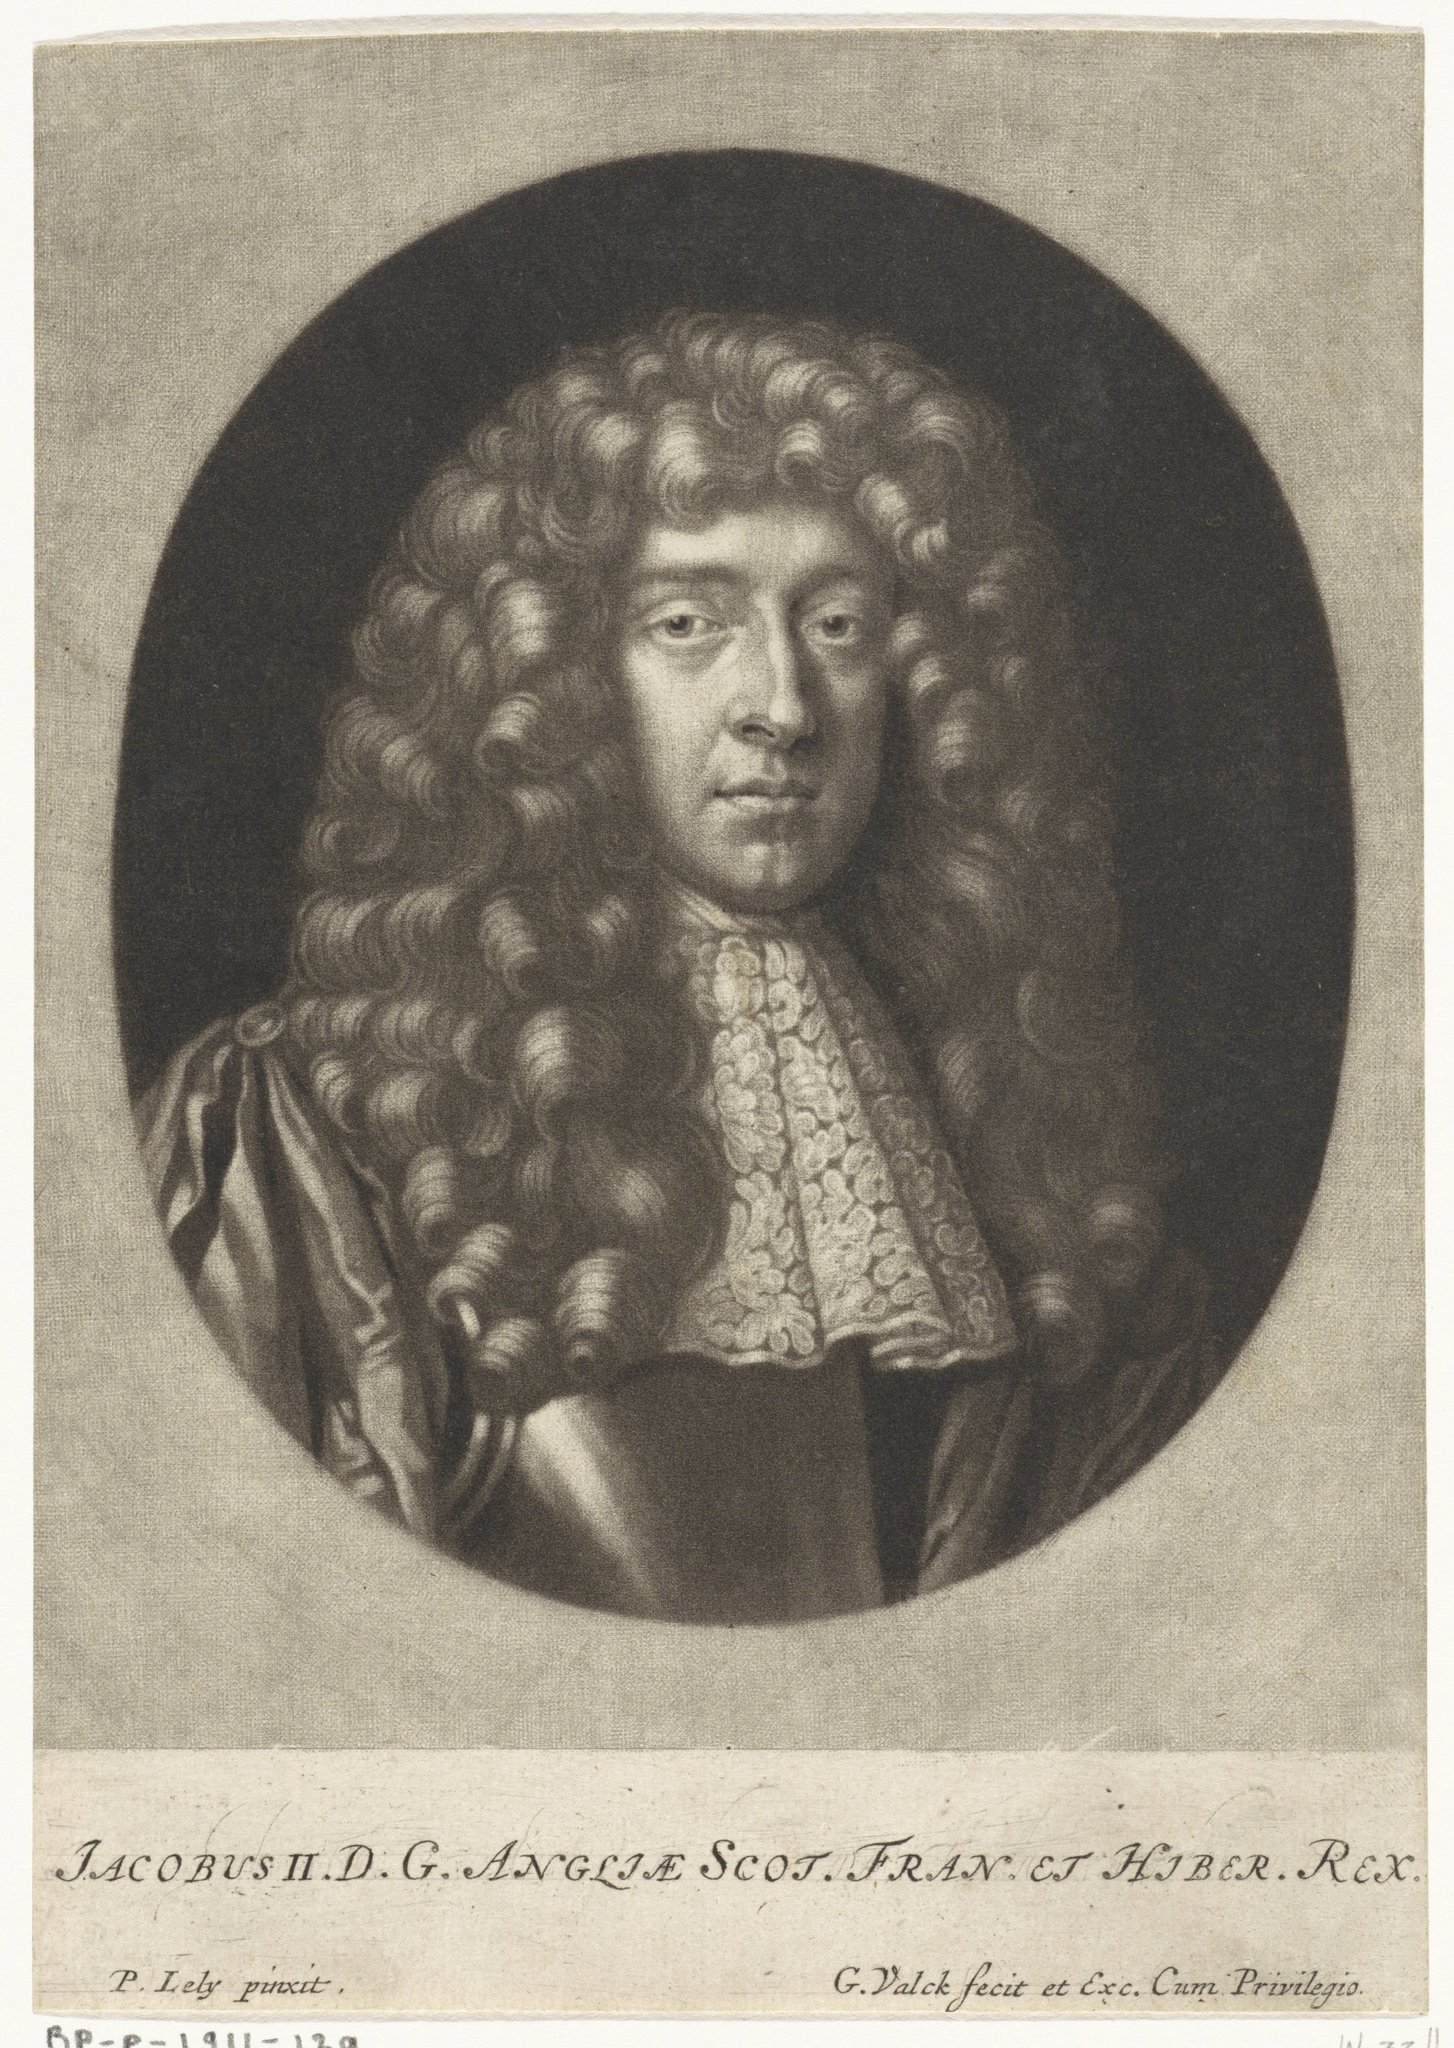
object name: print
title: Portret van Jacobus II, koning van Engeland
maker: gerard valck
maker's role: print maker, publisher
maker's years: 1651-1726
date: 1662-1726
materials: paper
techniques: mezzotint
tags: jacobus ii (koning van engeland en schotland), wig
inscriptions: collector's mark: Lugt 2228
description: Jacobus II Stuart, koning van Engeland en als Jacobus VII, koning van Schotland.